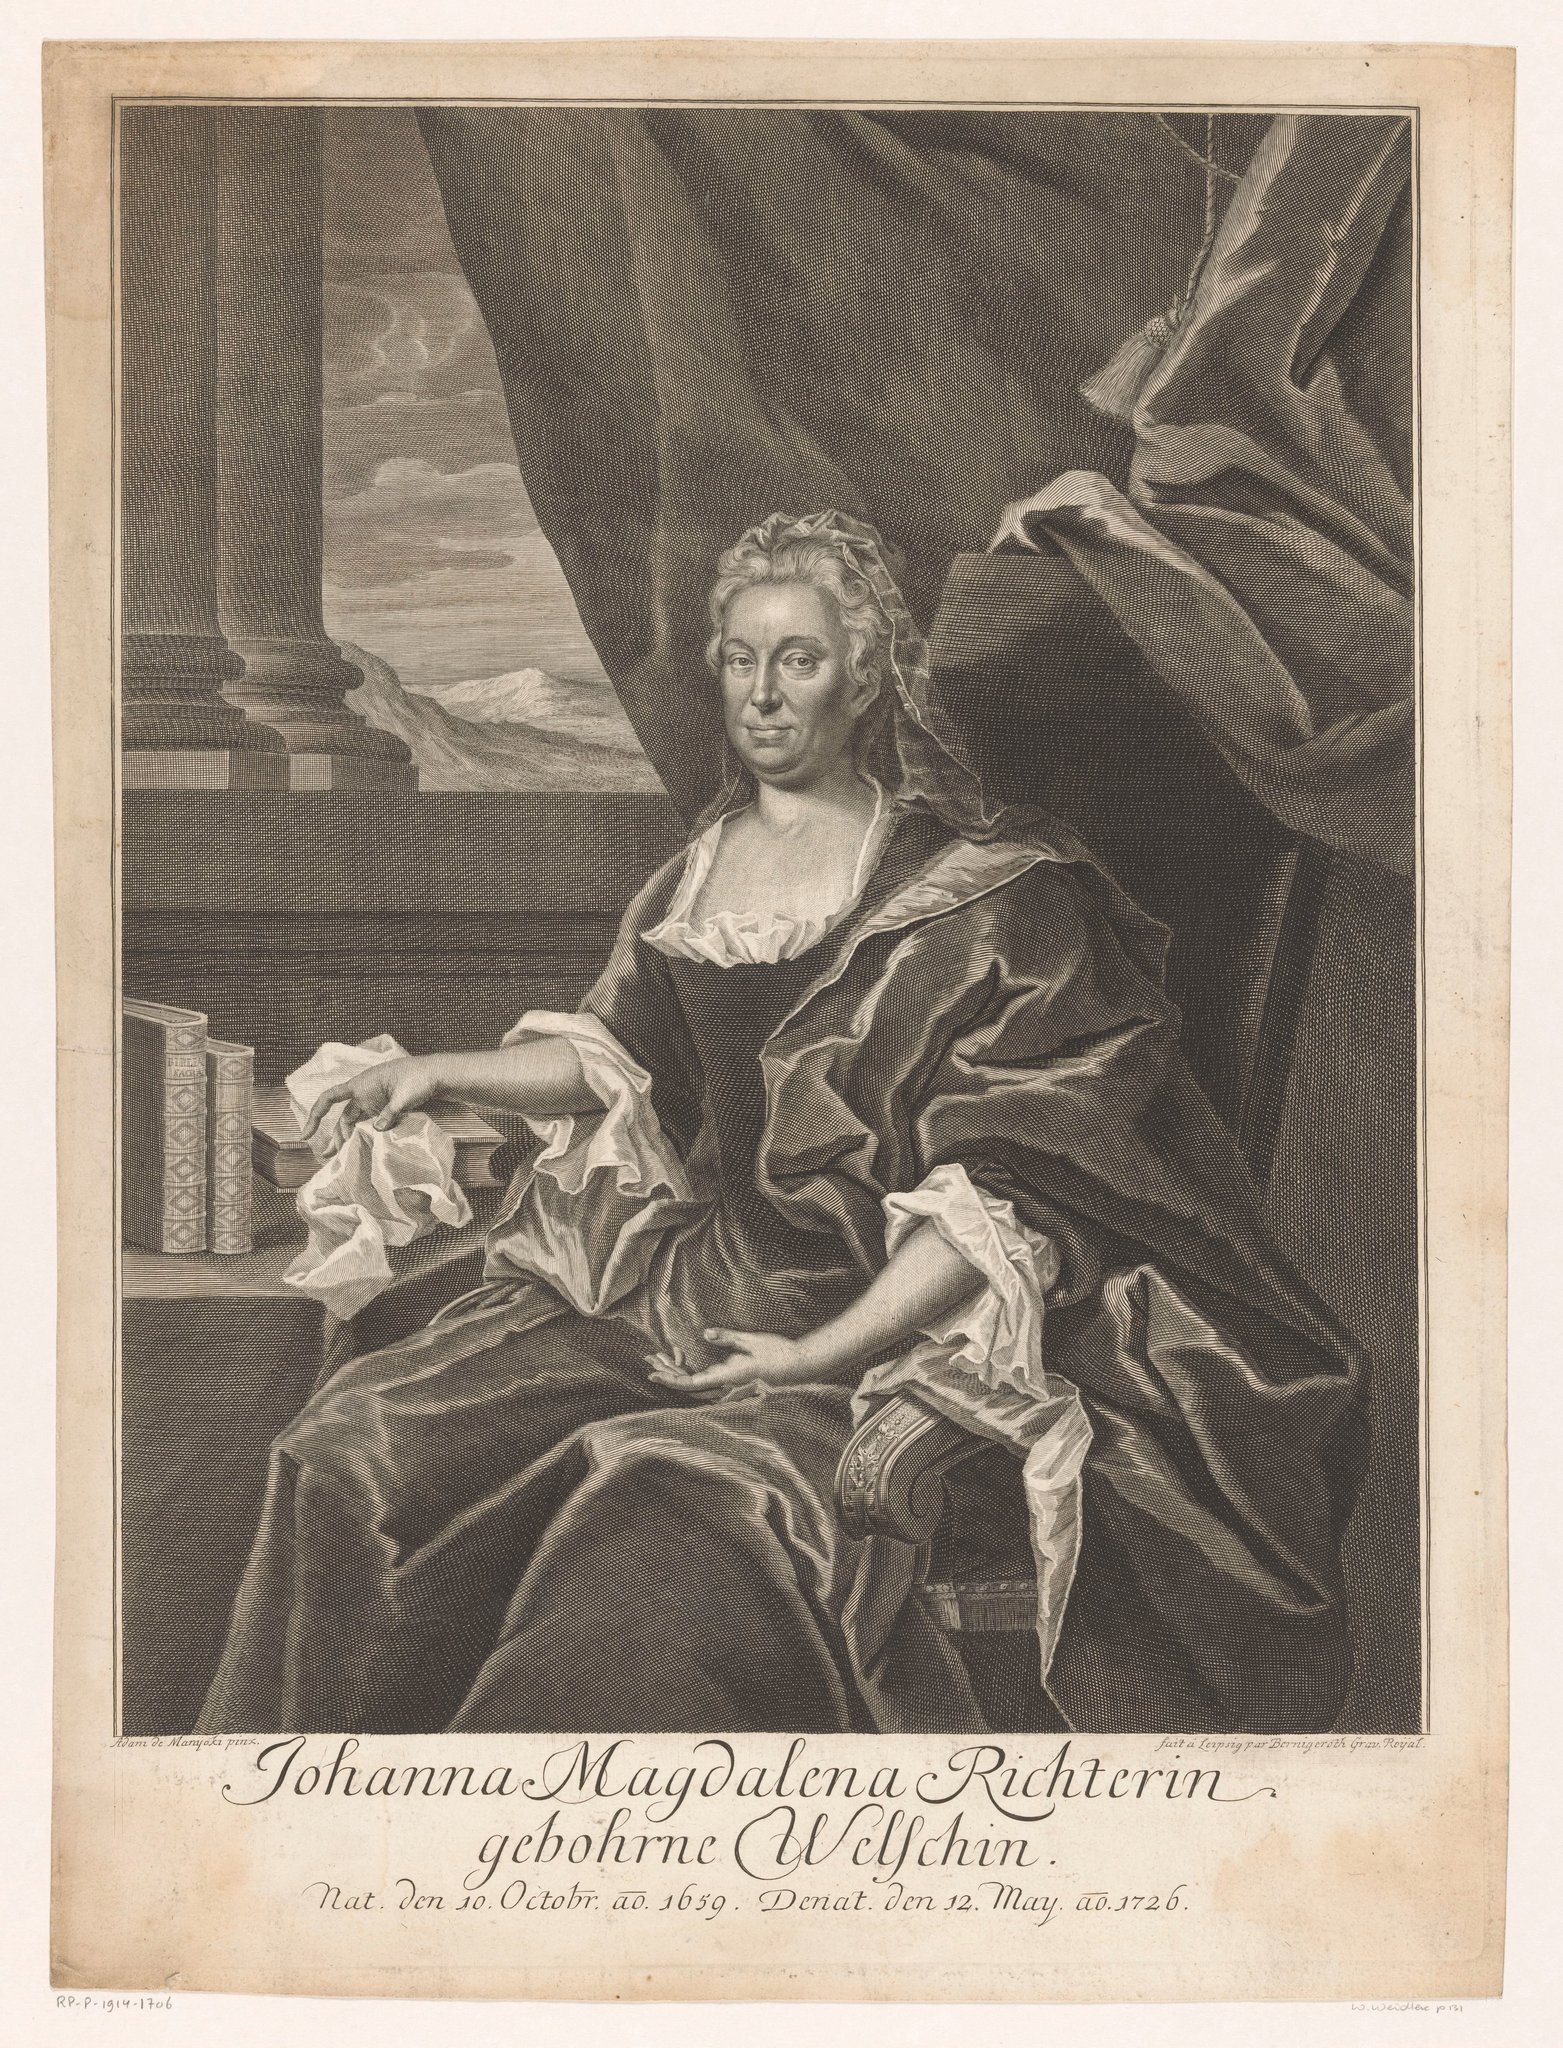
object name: print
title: Portret van Johann Magdalena Richter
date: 1726-1733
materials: paper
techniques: engraving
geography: leipzig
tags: historical persons - bb - woman, book, the bible as a book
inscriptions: collector's mark: Lugt 2228